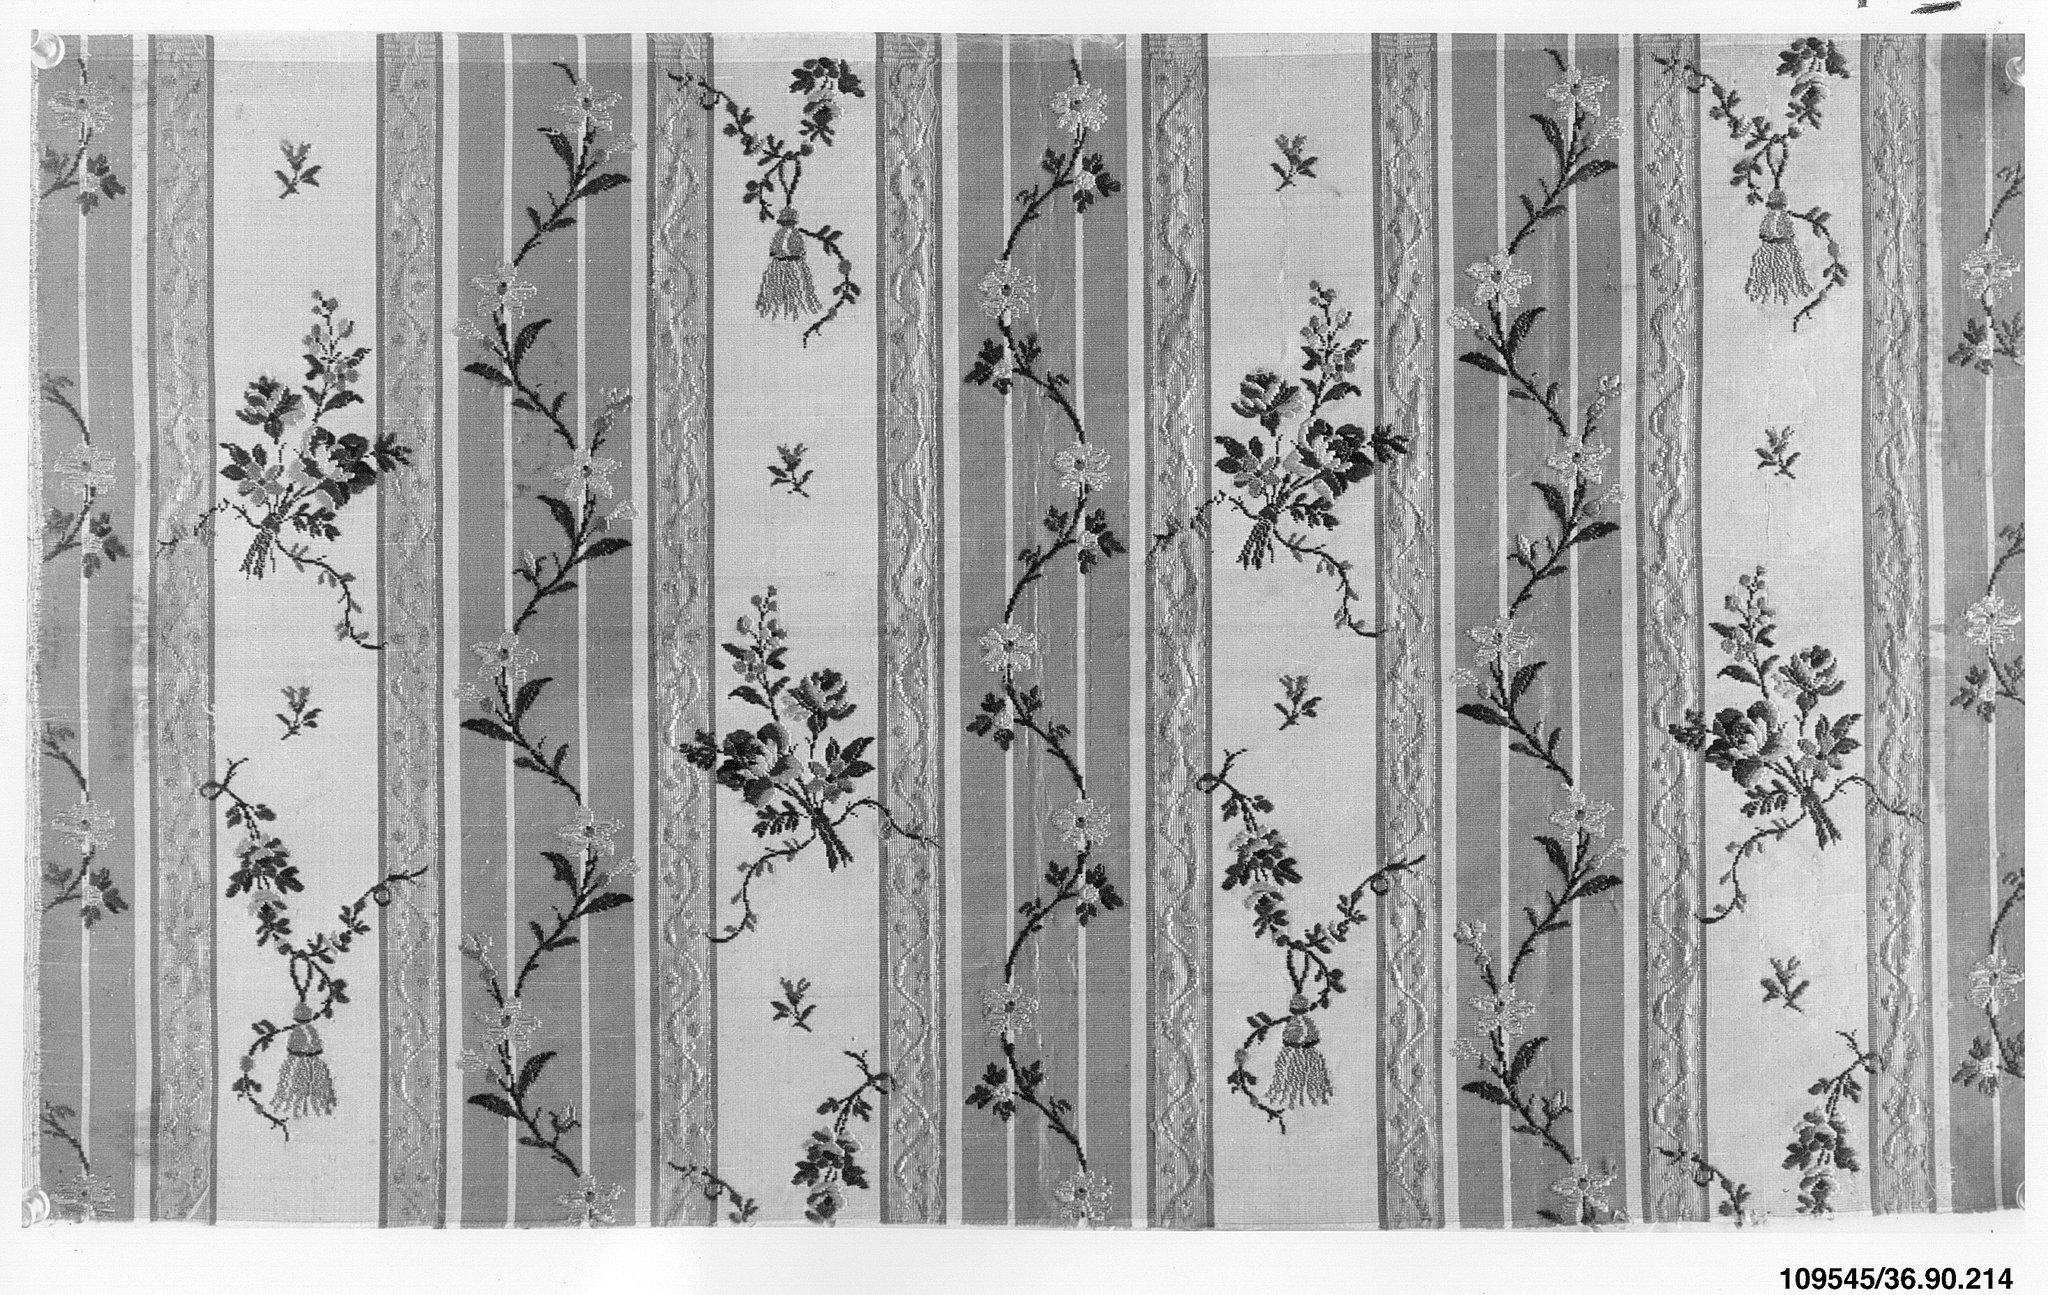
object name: piece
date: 1701-1800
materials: metal thread, silk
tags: flowers